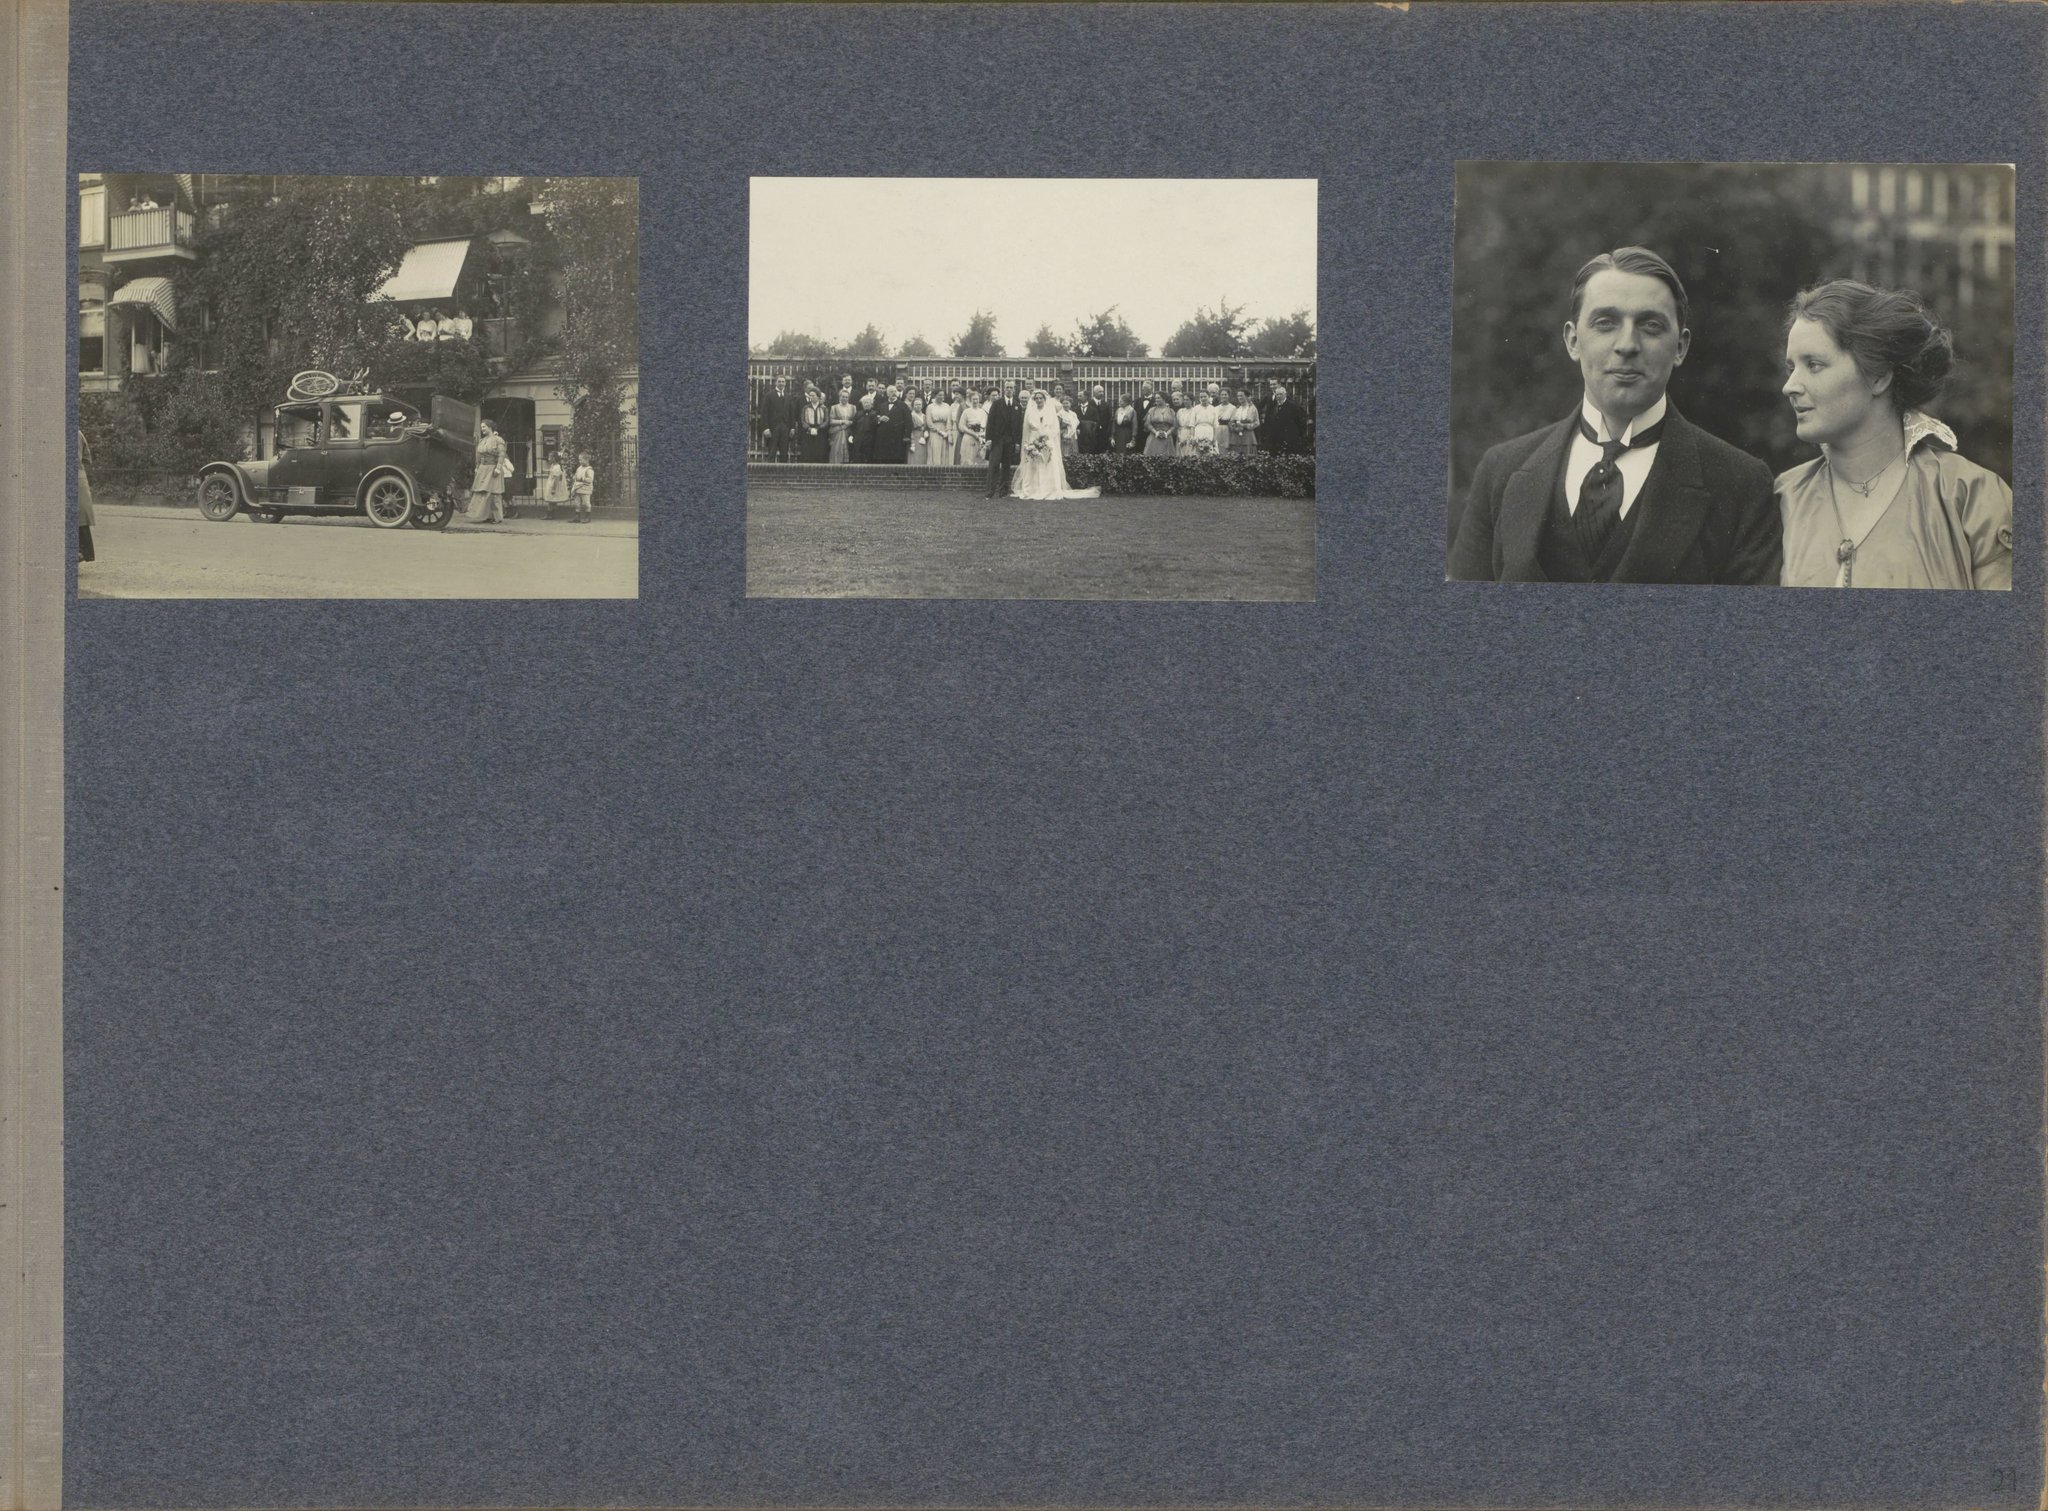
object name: photograph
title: Bruiloft Jan en Liesbeth Croockewit (2)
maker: Anonymous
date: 1910-1911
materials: cardboard, paper, photographic support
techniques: gelatin silver print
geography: netherlands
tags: wedding trip, honeymoon, bride and groom in wedding-dress, netherlands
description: Albumblad met drie foto's genomen tijdens de bruiloft van Jan en Liesbeth Croockewit. Centraal een groepsportret van het bruidspaar en hun gasten, links een met fietsen beladen auto voor een huis en rechts een portret van een man en een vrouw. Onderdeel van Fotoalbum van de familie Palthe uit Almelo.